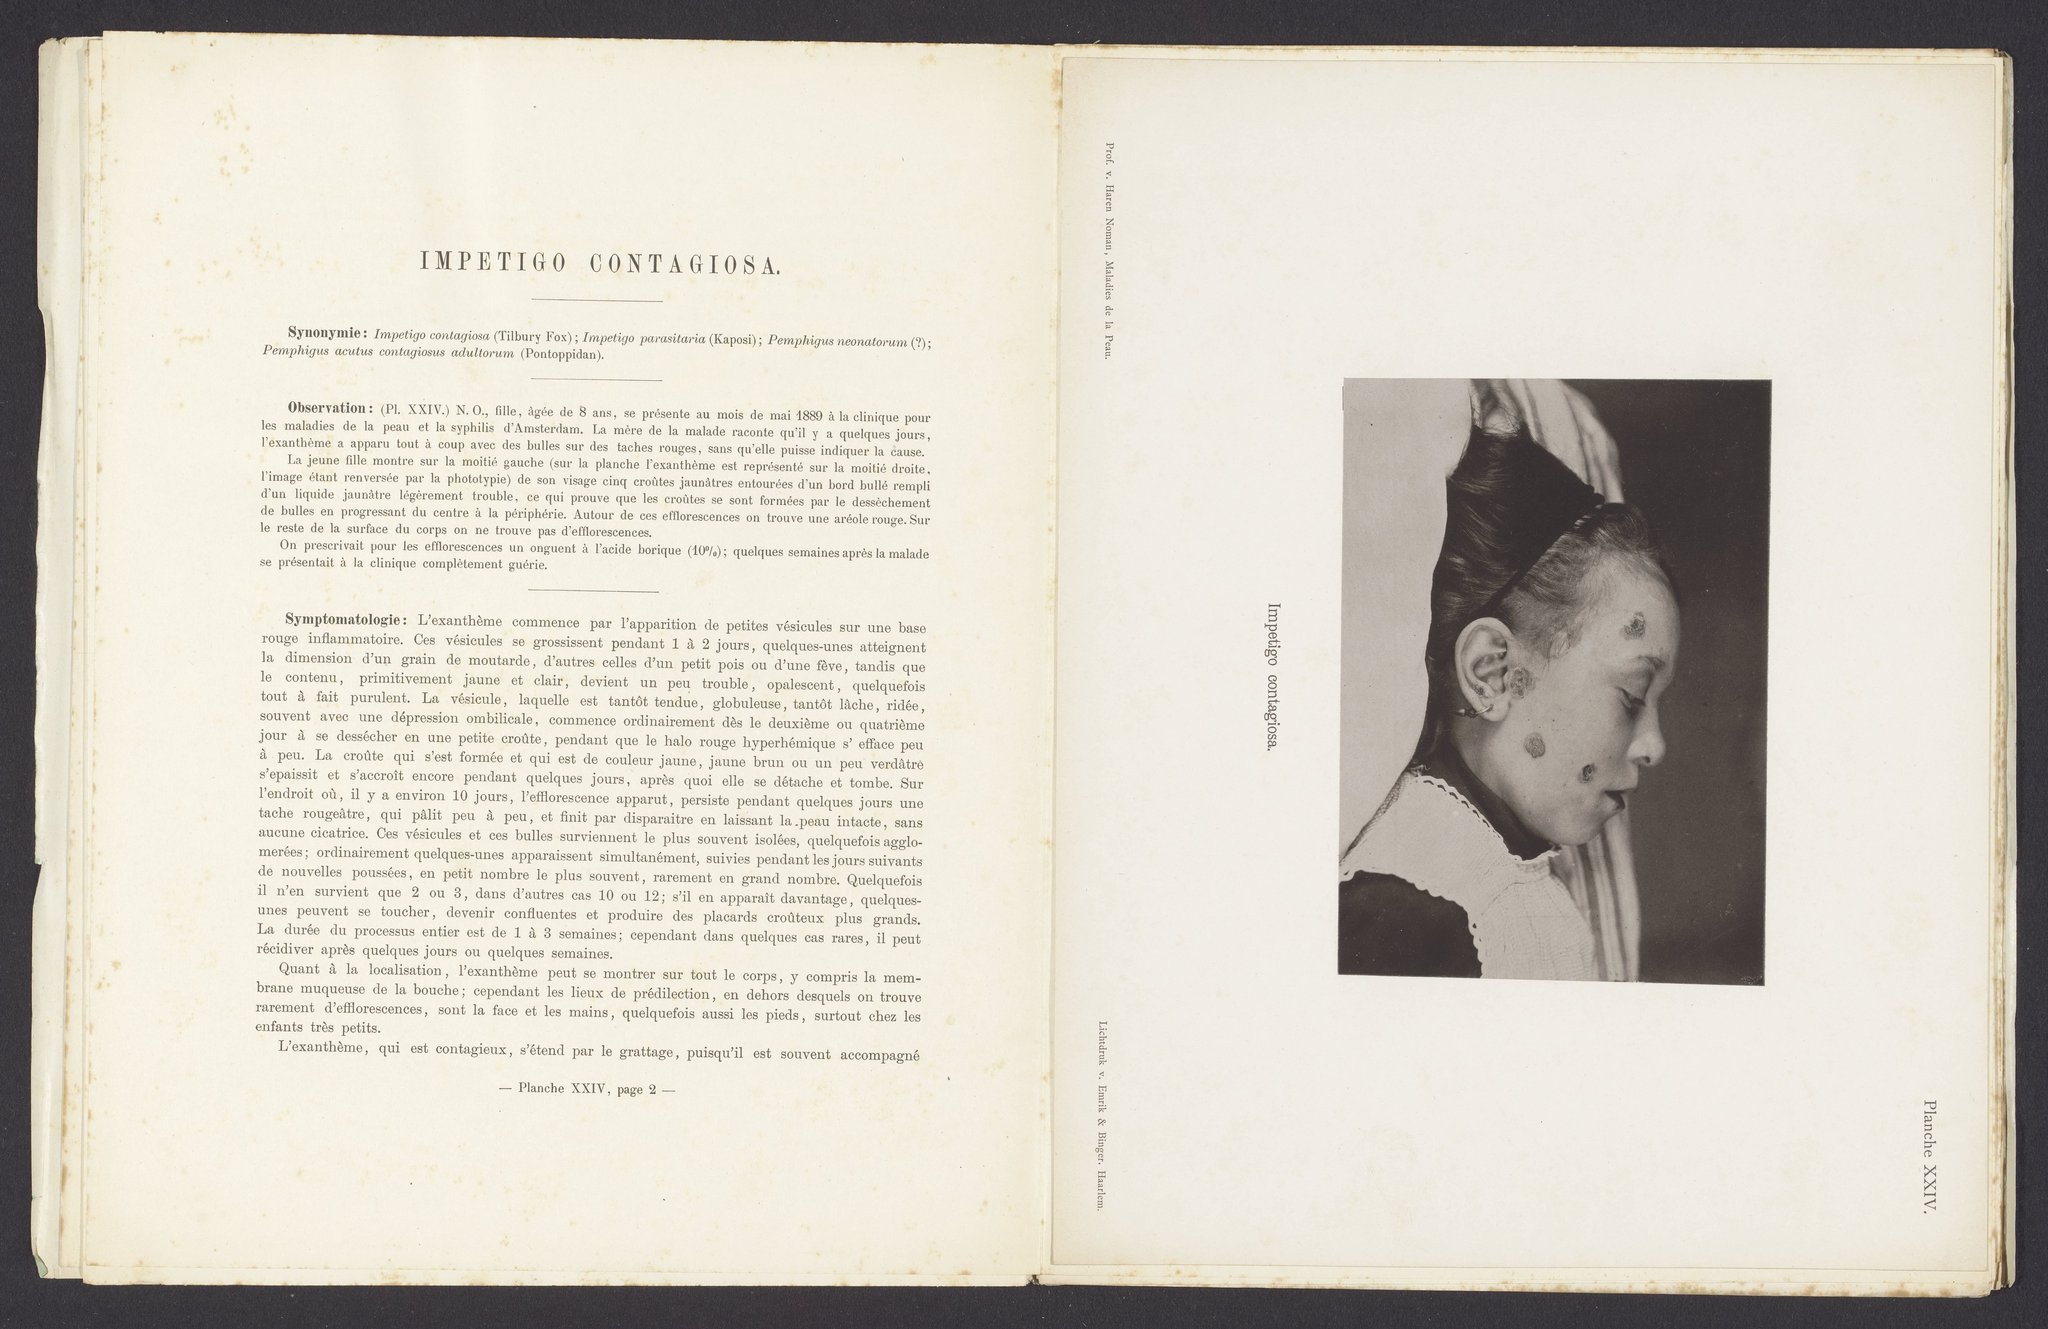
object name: page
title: Patiënt lijdend aan de huidziekte 'impetigo contagiosa'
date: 1883-1893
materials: paper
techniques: photograph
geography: haarlem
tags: face, skin and venereal diseases, child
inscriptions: number: ‘Planche XXIV.’